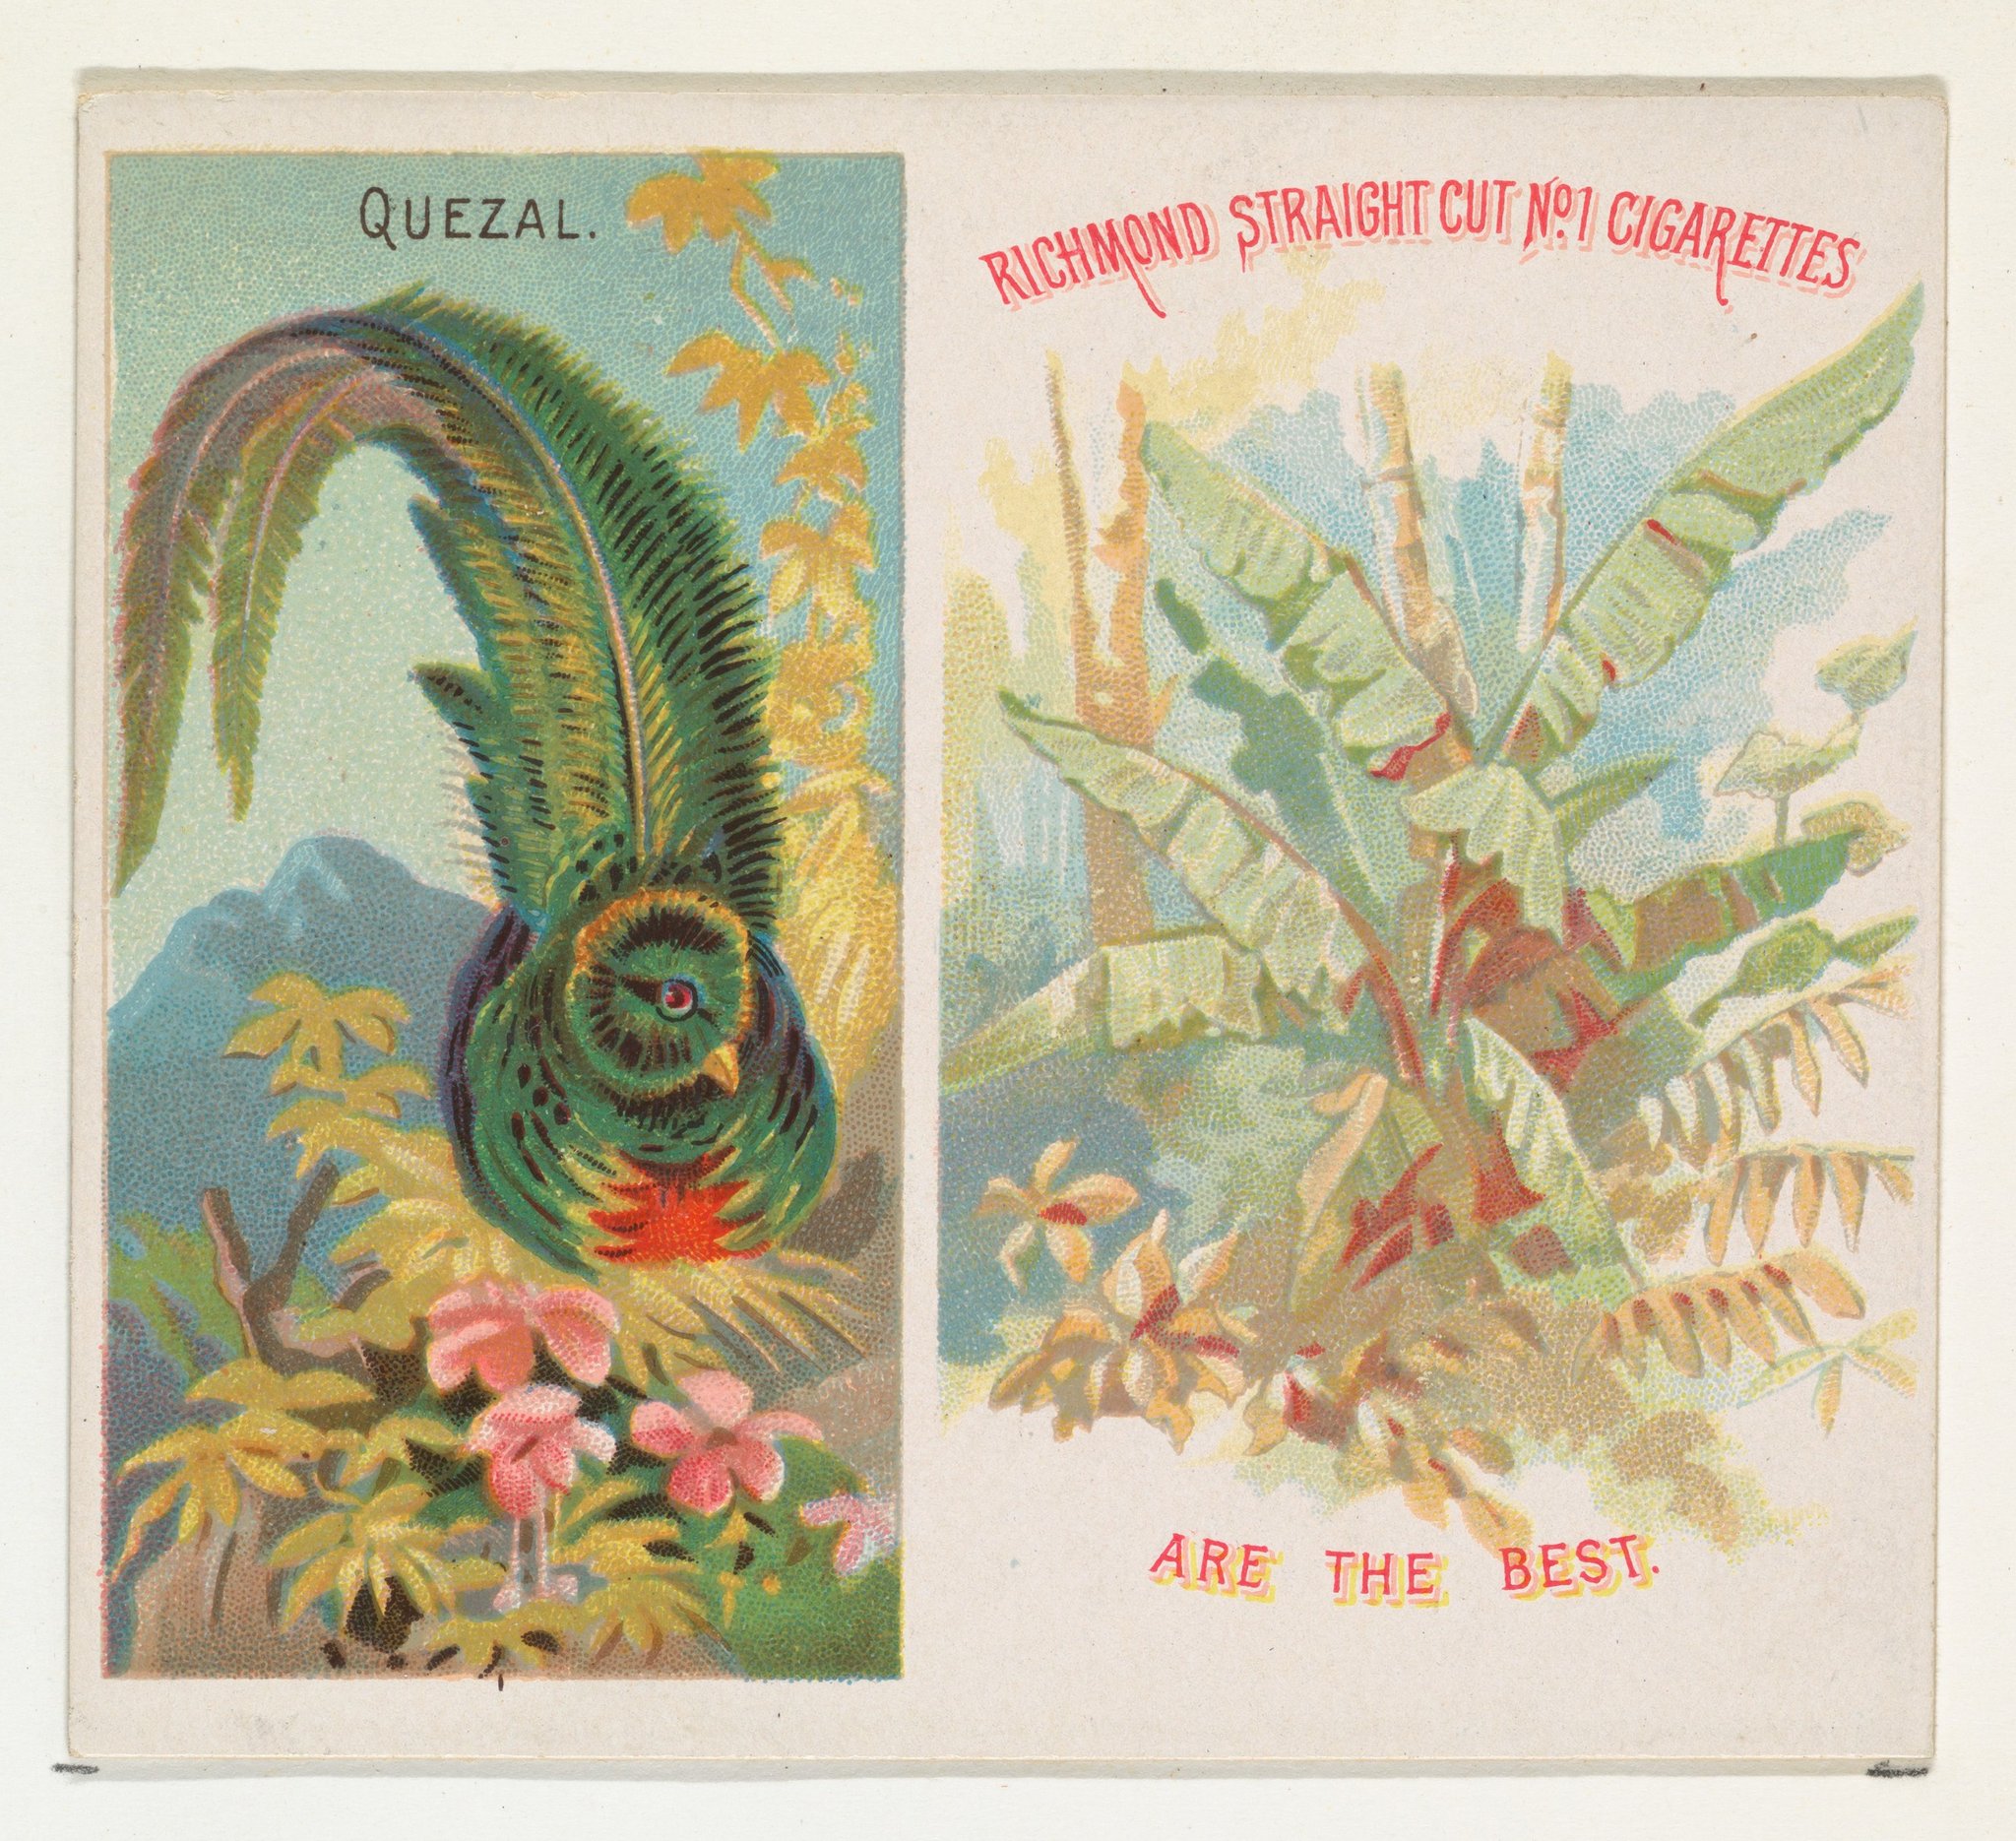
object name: print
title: Quezal, from Birds of the Tropics series (N38) for Allen & Ginter Cigarettes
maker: allen & ginter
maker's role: publisher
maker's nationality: american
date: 1889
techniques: color lithograph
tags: birds